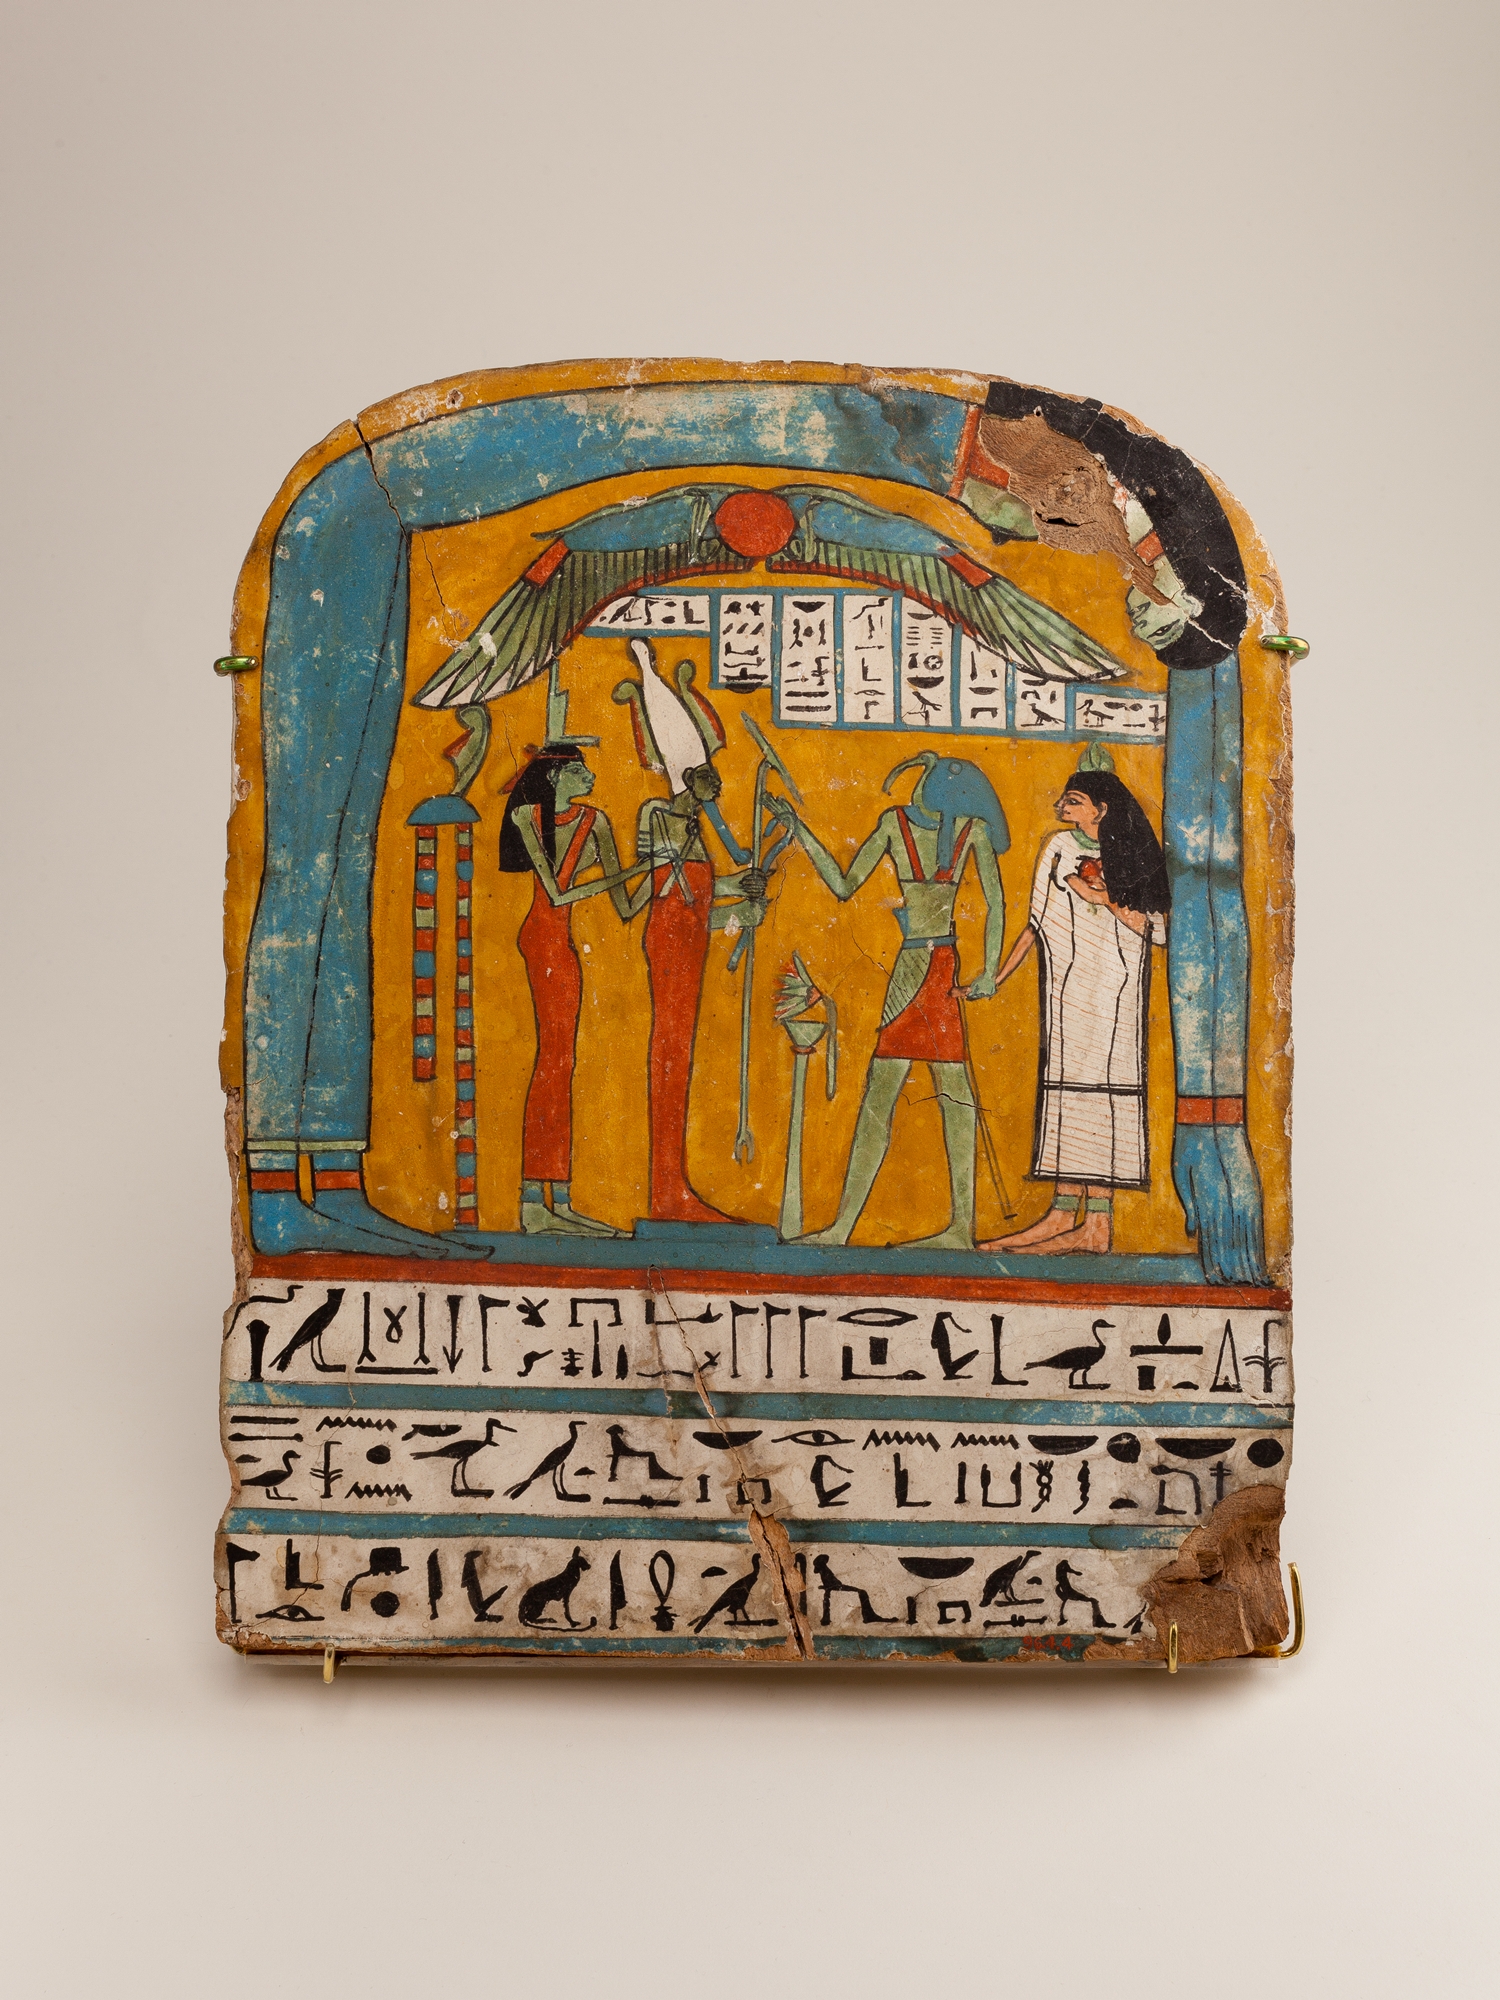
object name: stela, tabakenkhonsu, hor, tamiut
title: Painted wooden panel of Tabakenkhonsu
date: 680-670 BCE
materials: gesso, paint, wood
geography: egypt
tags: women,hieroglyphs